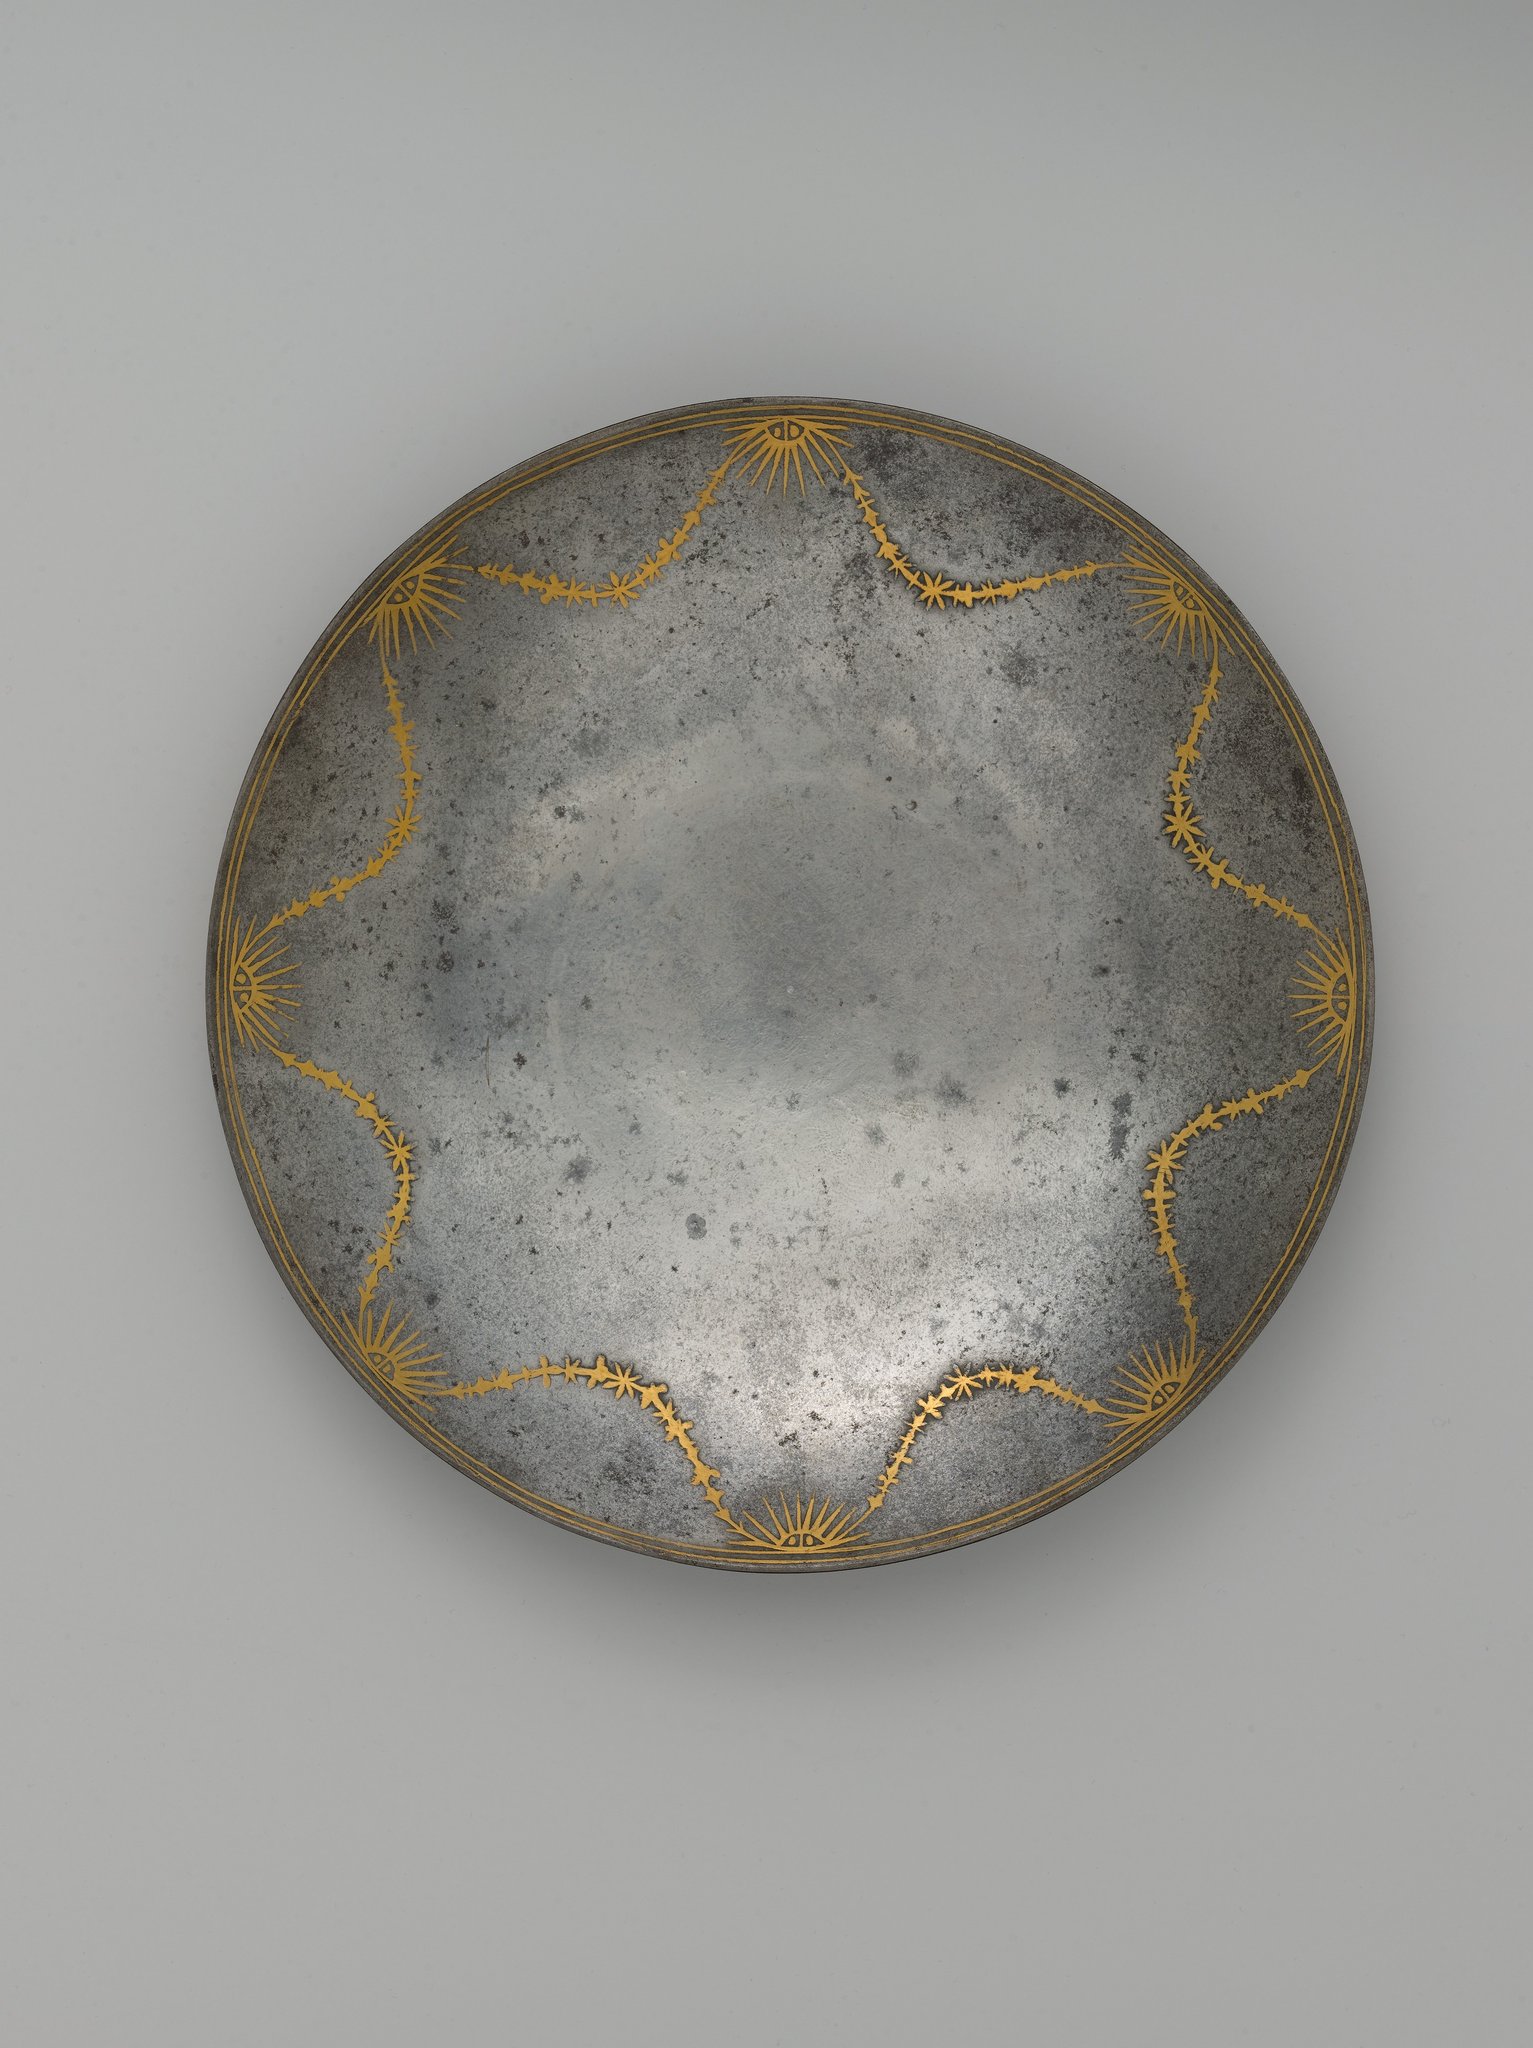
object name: saucer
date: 1801-1900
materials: gold, steel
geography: iran